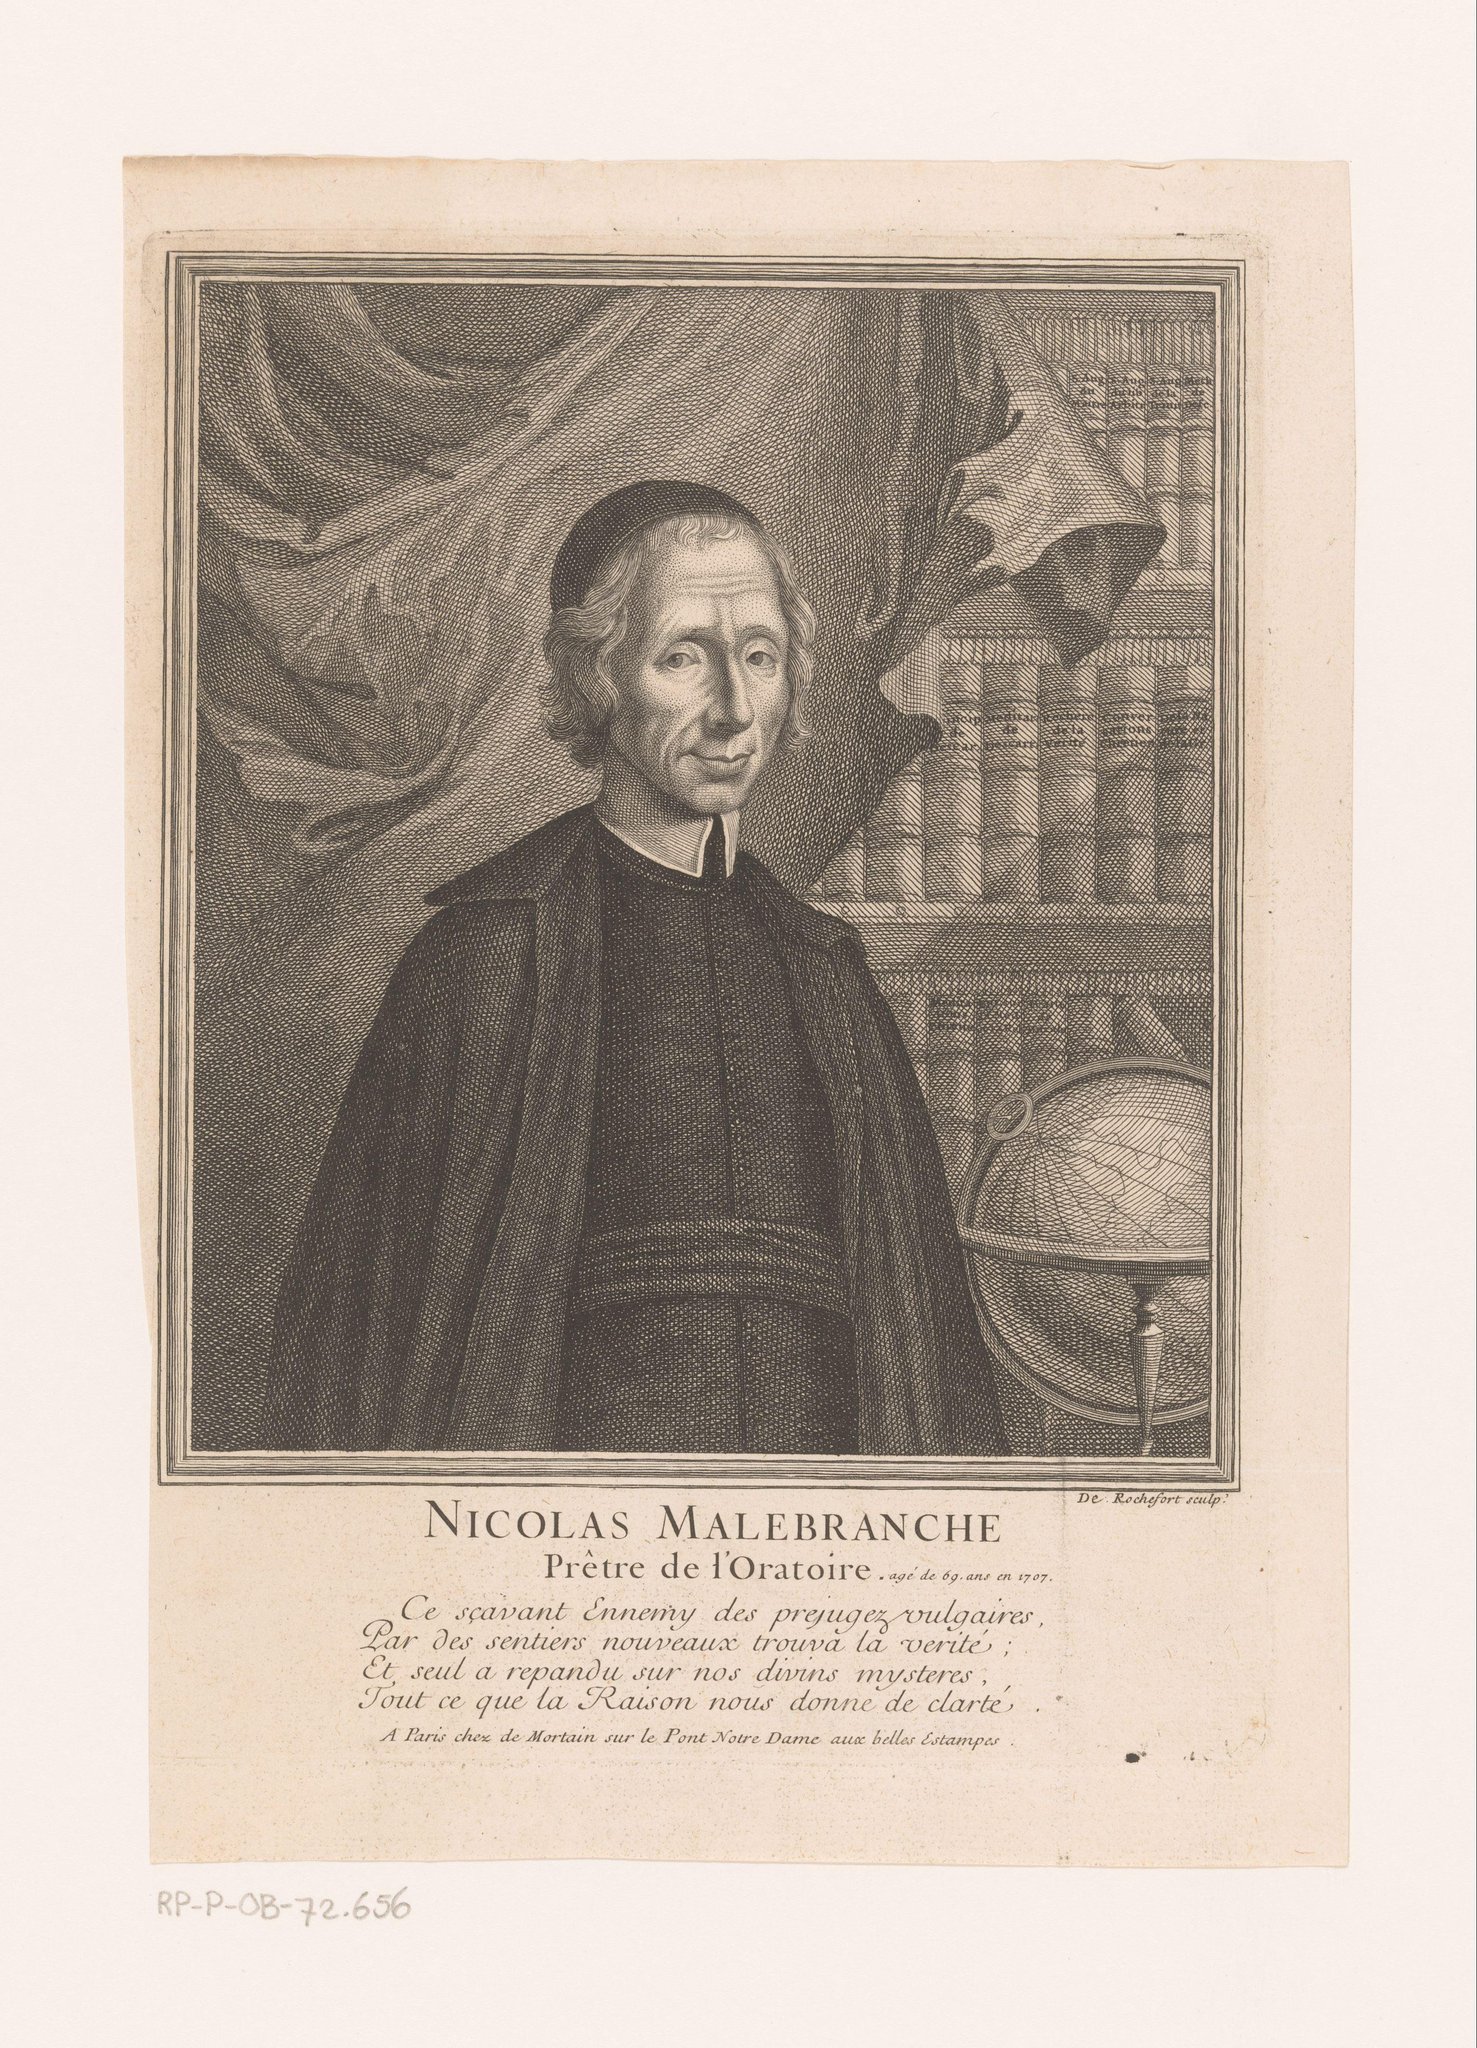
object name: print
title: Portret van Nicolas Malebranche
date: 1707-1733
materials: paper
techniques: engraving, etching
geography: paris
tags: paris, priest (roman catholic), scholar, philosopher, historical persons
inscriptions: collector's mark: Lugt 2228